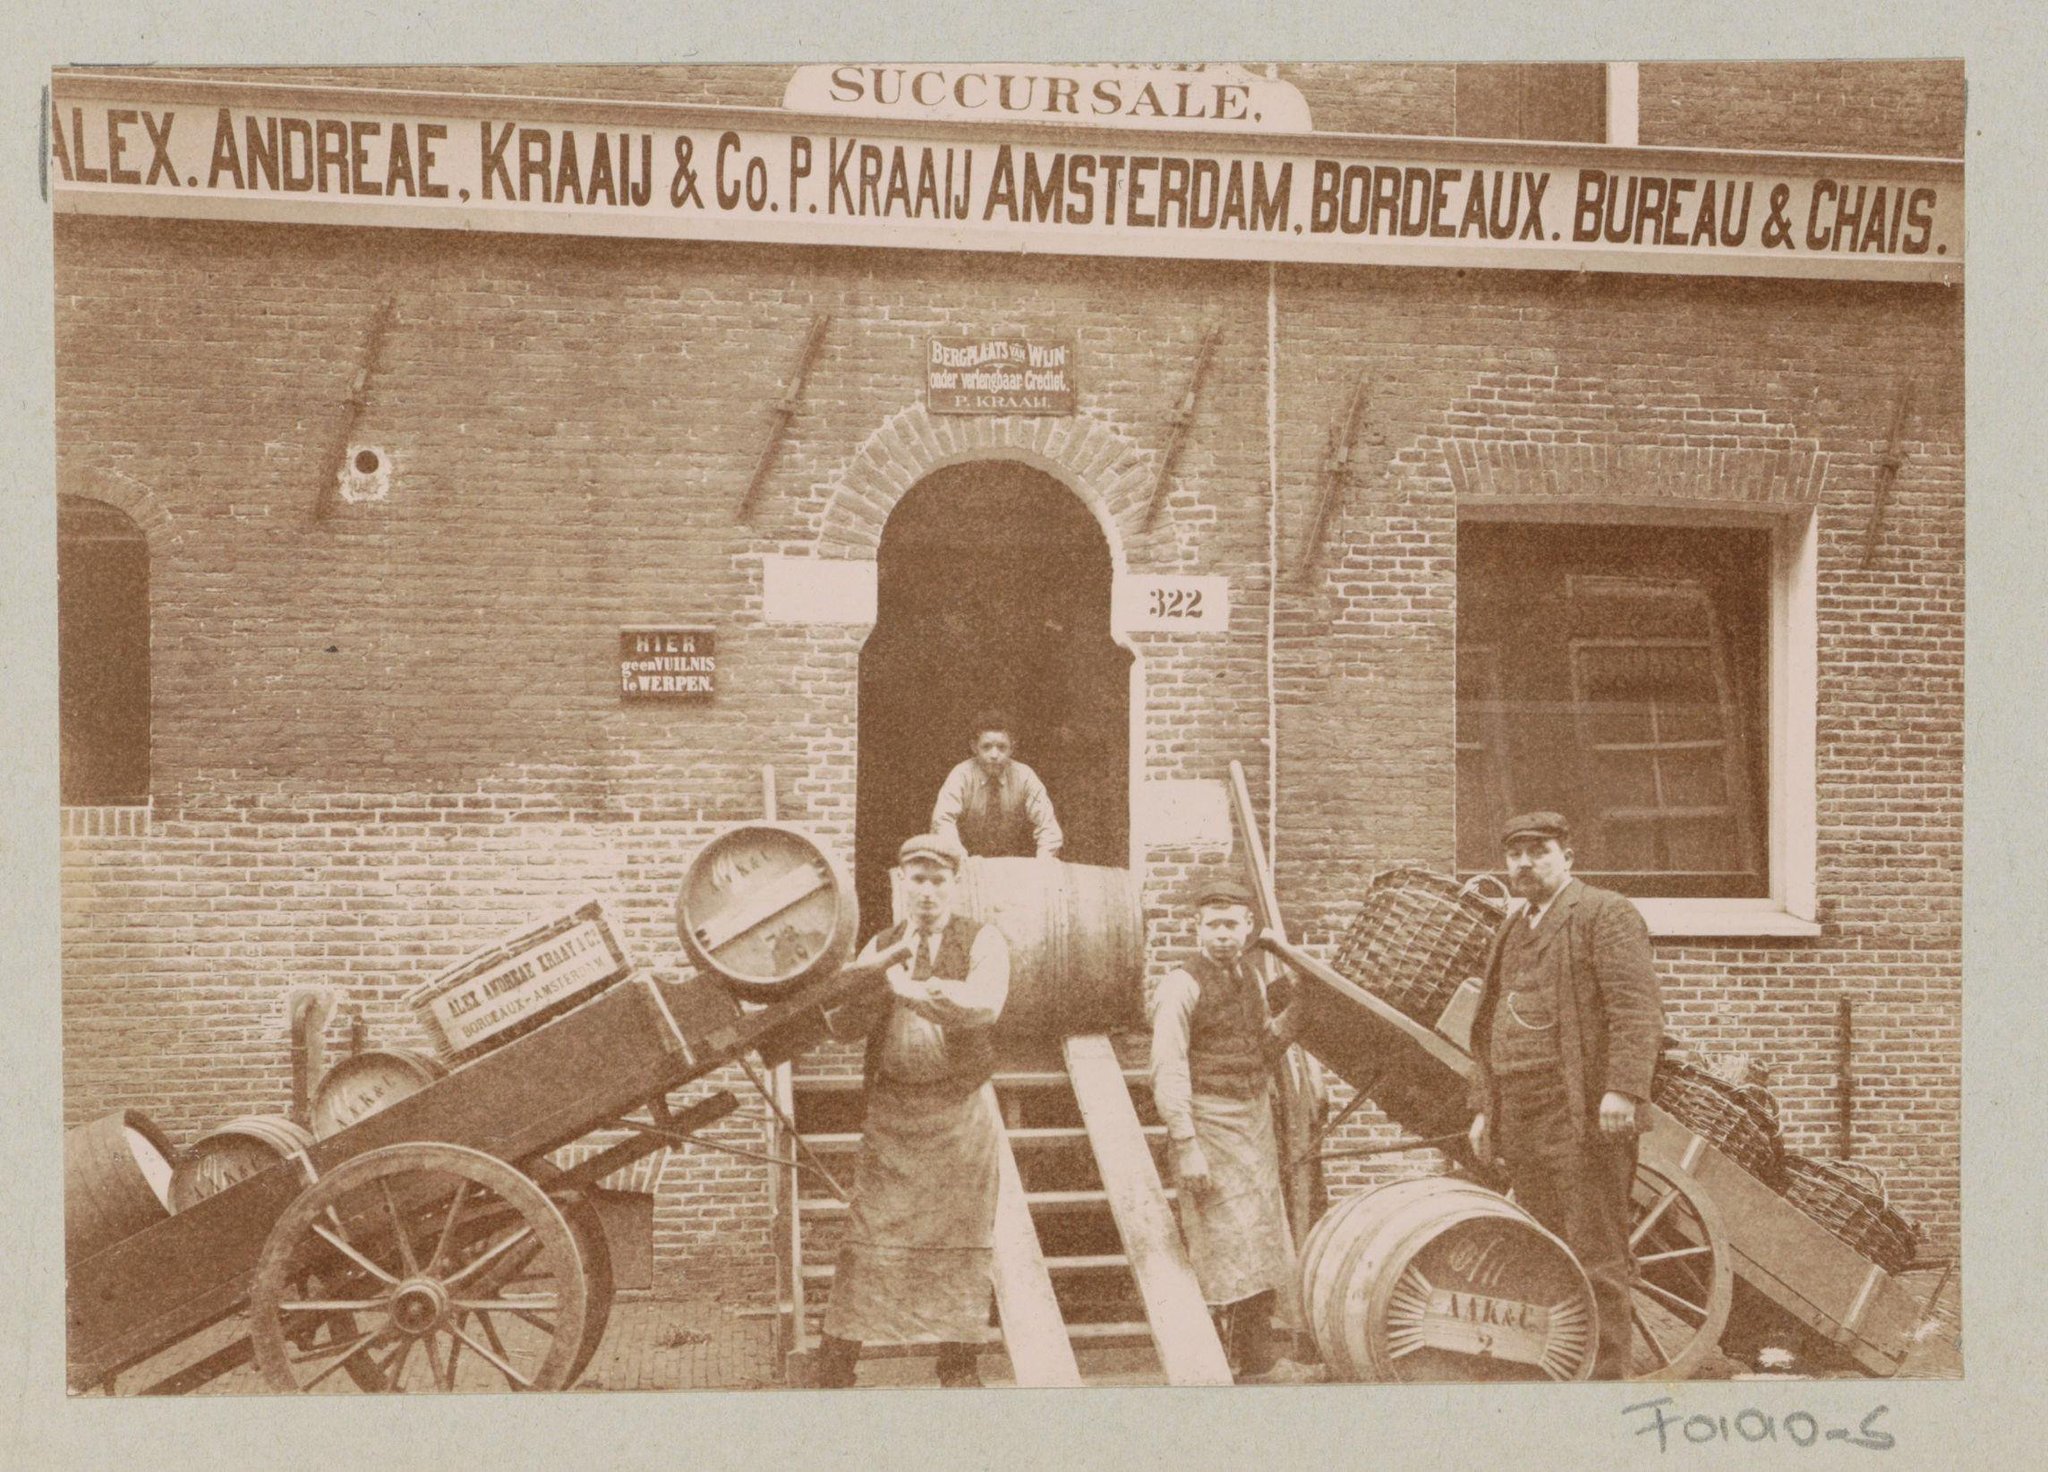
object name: photograph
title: Personeel van Kraaij en Co. verricht laad- en loswerkzaamheden met vaten en karren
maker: Anonymous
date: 1900-1910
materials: photographic support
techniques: daylight paper print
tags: wooden container: barrel, cask (+ wood and other phytogenic material), packing of products (+ men (labourers)), large-scale structure for storage, e.g.: warehouse, depot, silo (+ men (labourers))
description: Mannen rollen vaten naar beneden langs een trap. Boven de toegangspoort een bord met het opschrift 'Alex. Andreae. Kraaij & Co. P. Kraaij Amsterdam. Bordeaux. Bureau & Chais.'. Onderdeel van Familiealbum met onder meer foto's van Wijnhandel Kraaij & Co. Bordeaux op de Kerkstraat 322 te Amsterdam